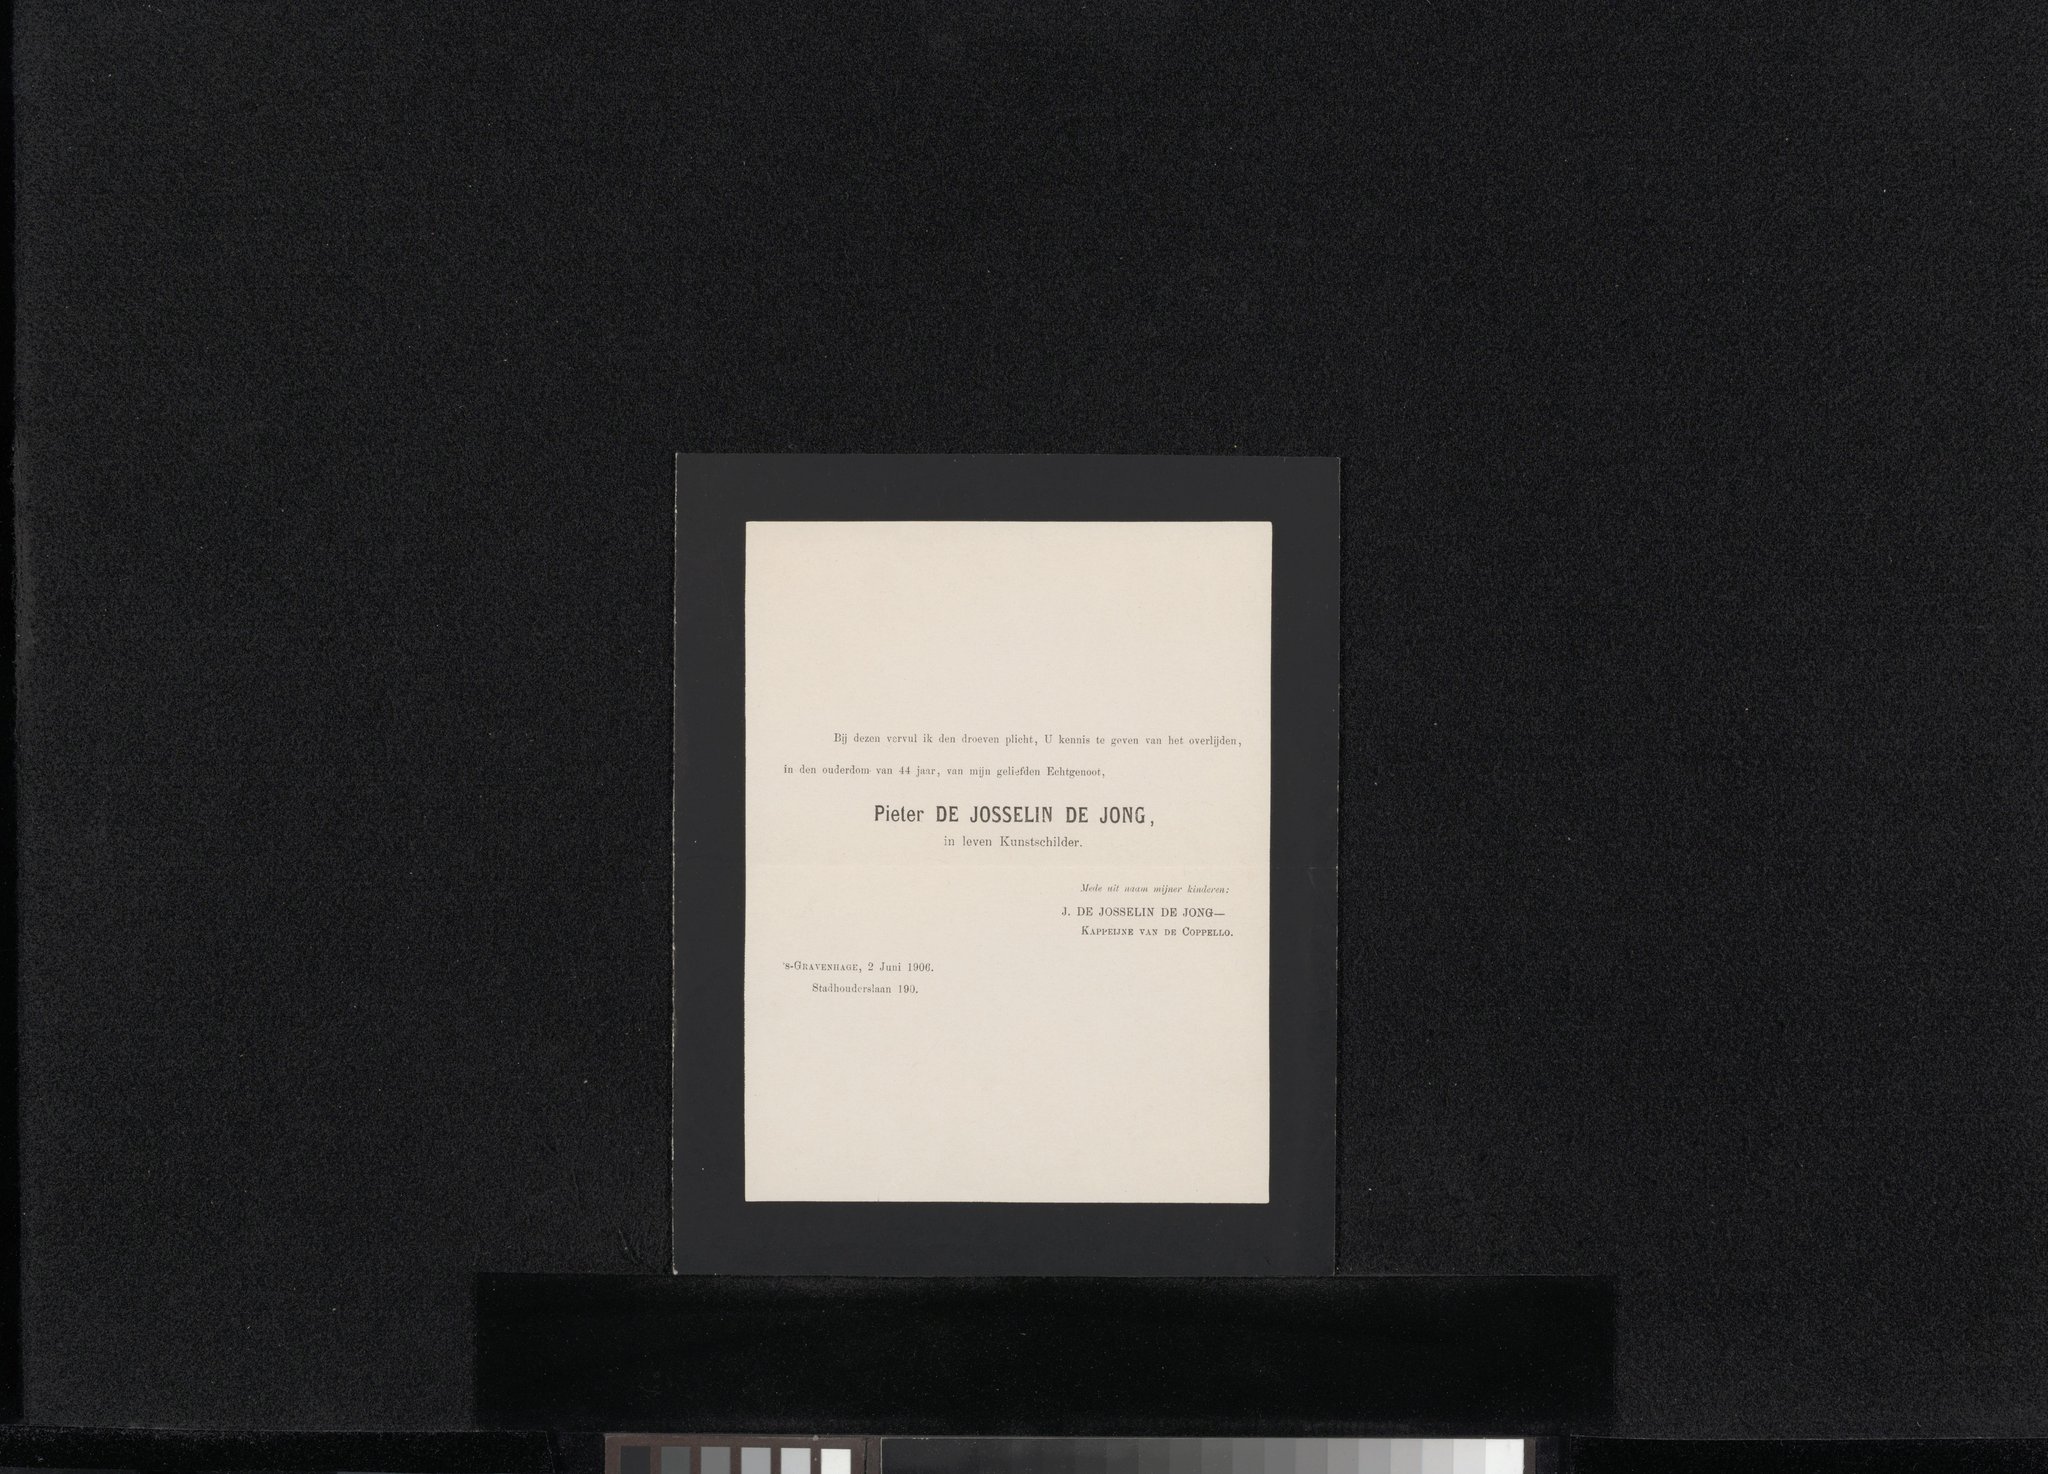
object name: overlijdensbericht, overlijdensadvertentie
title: Overlijdensbericht Pieter de Josselin de Jong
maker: Anonymous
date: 1906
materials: paper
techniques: printing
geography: the hague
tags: amsterdam, painter, print maker, draughtsman, pieter de josselin de jong